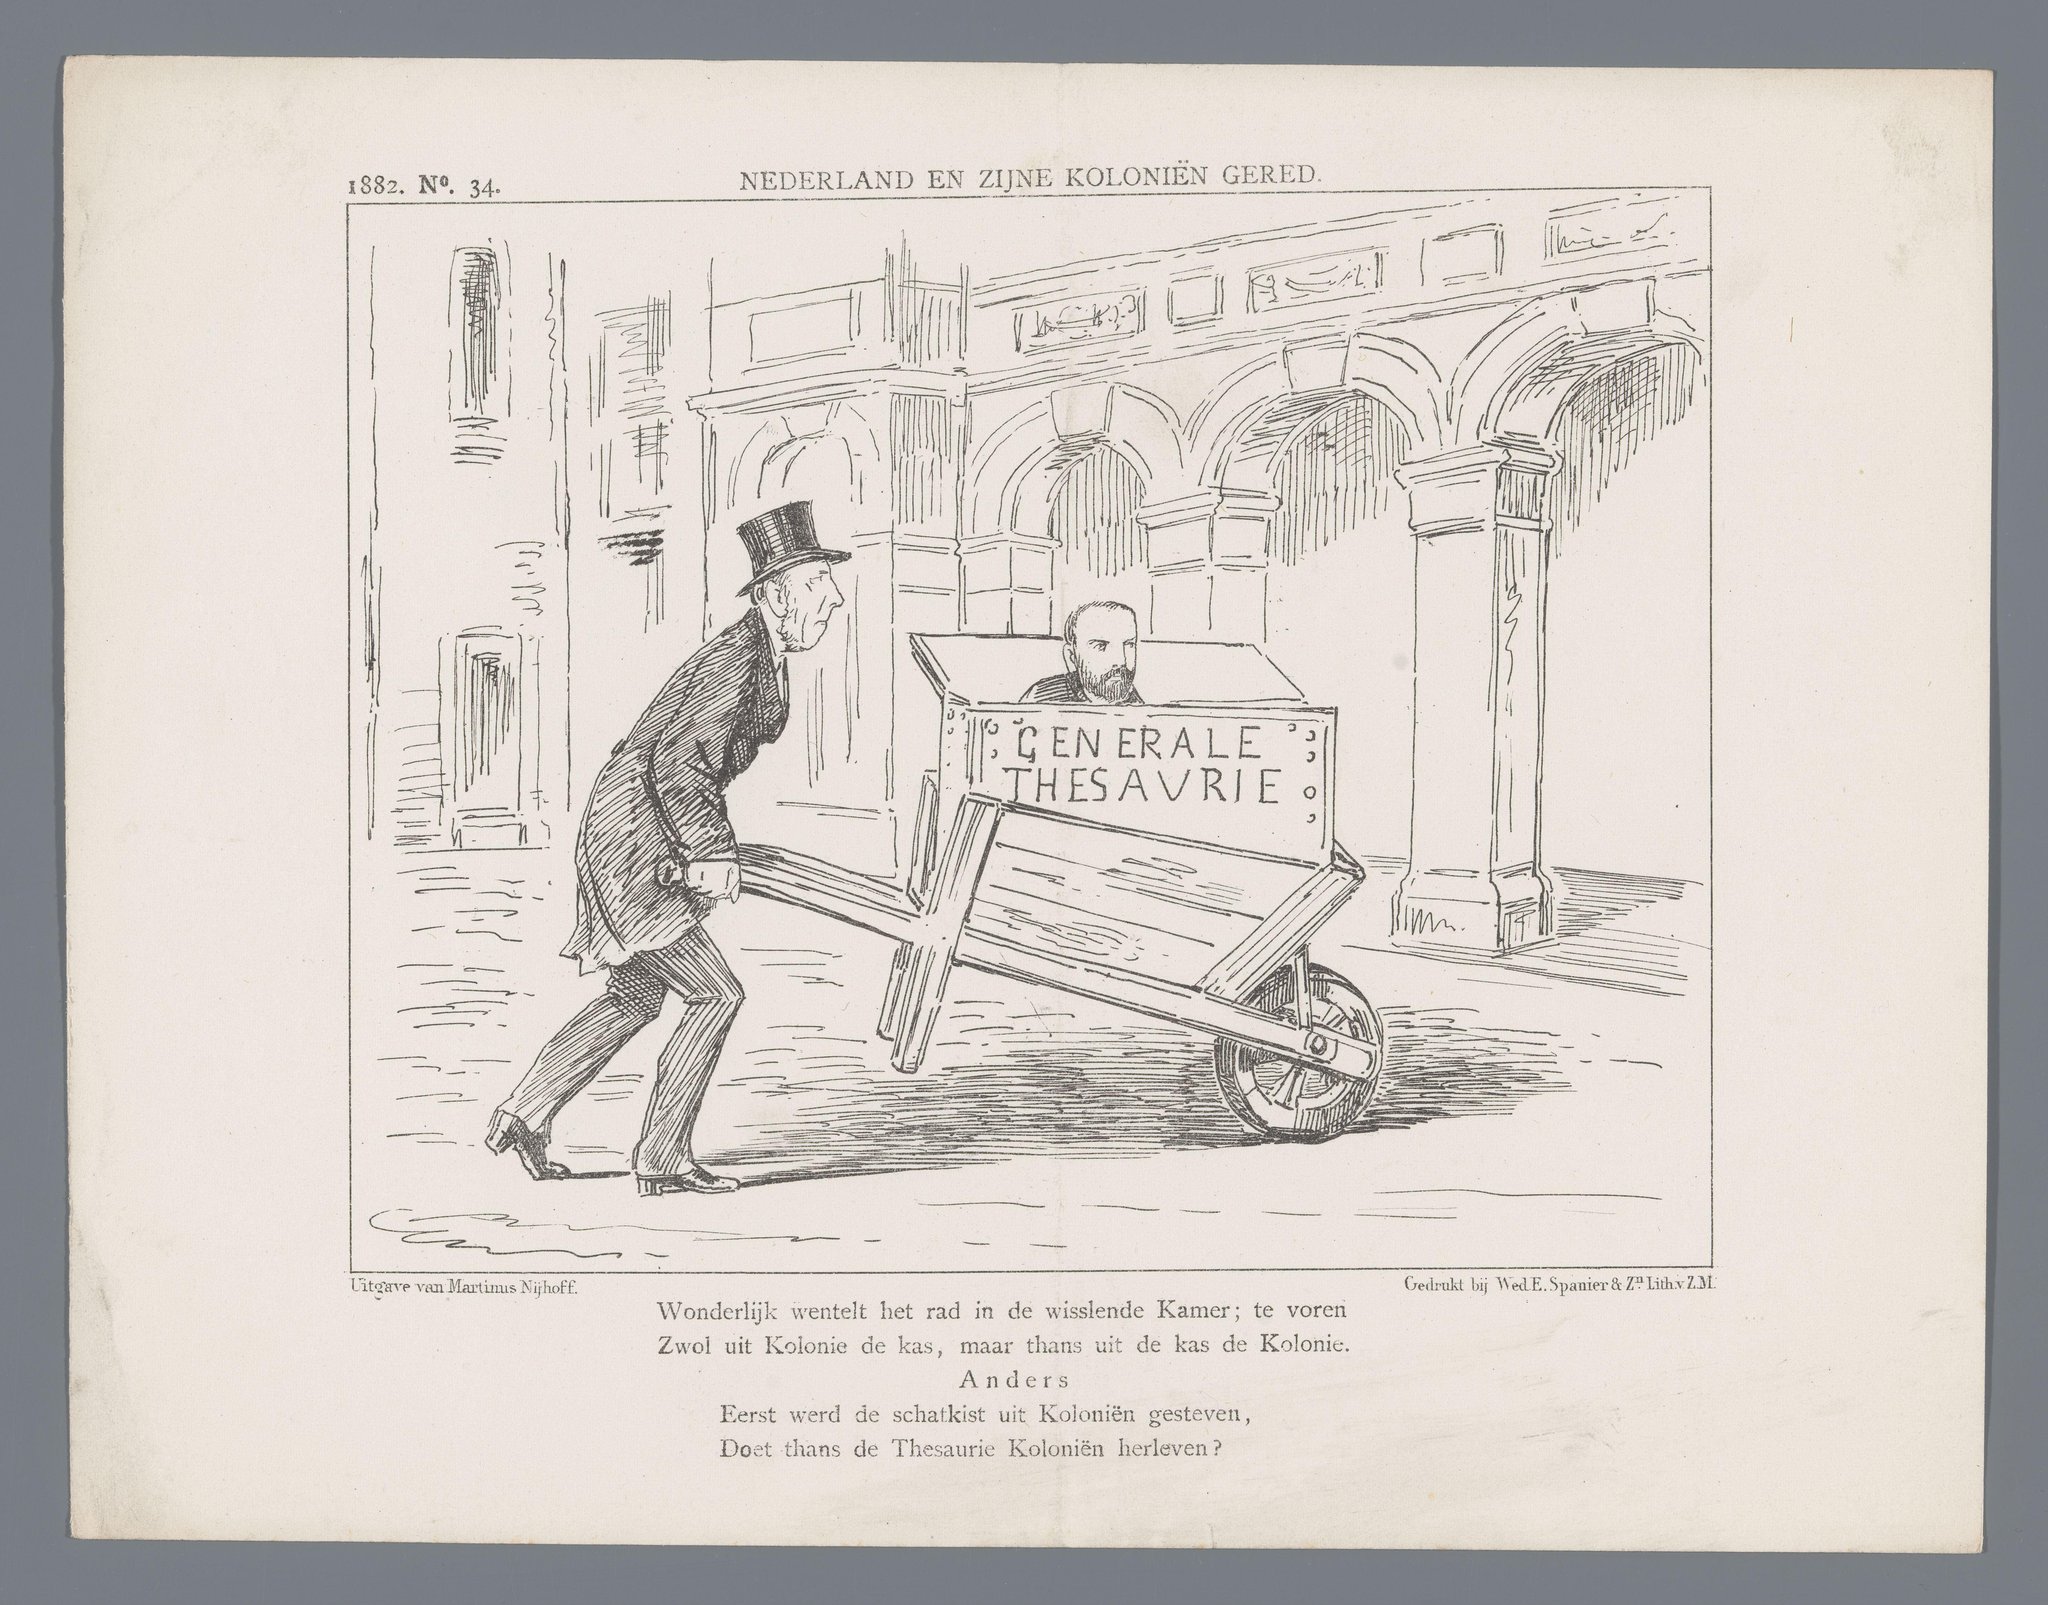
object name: cartoon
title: Nederland en zijne koloniën gered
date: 1882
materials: paper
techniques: lithograph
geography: netherlands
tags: constantijn theodore lynden van sandenburg, binnenhof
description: Politieke spotprent met minister van Lynden van Sandenburg met een kruiwagen op het Binnenhof. Plaat verschenen bij het weekblad De Nederlandsche Spectator, nr. 34, 1882.